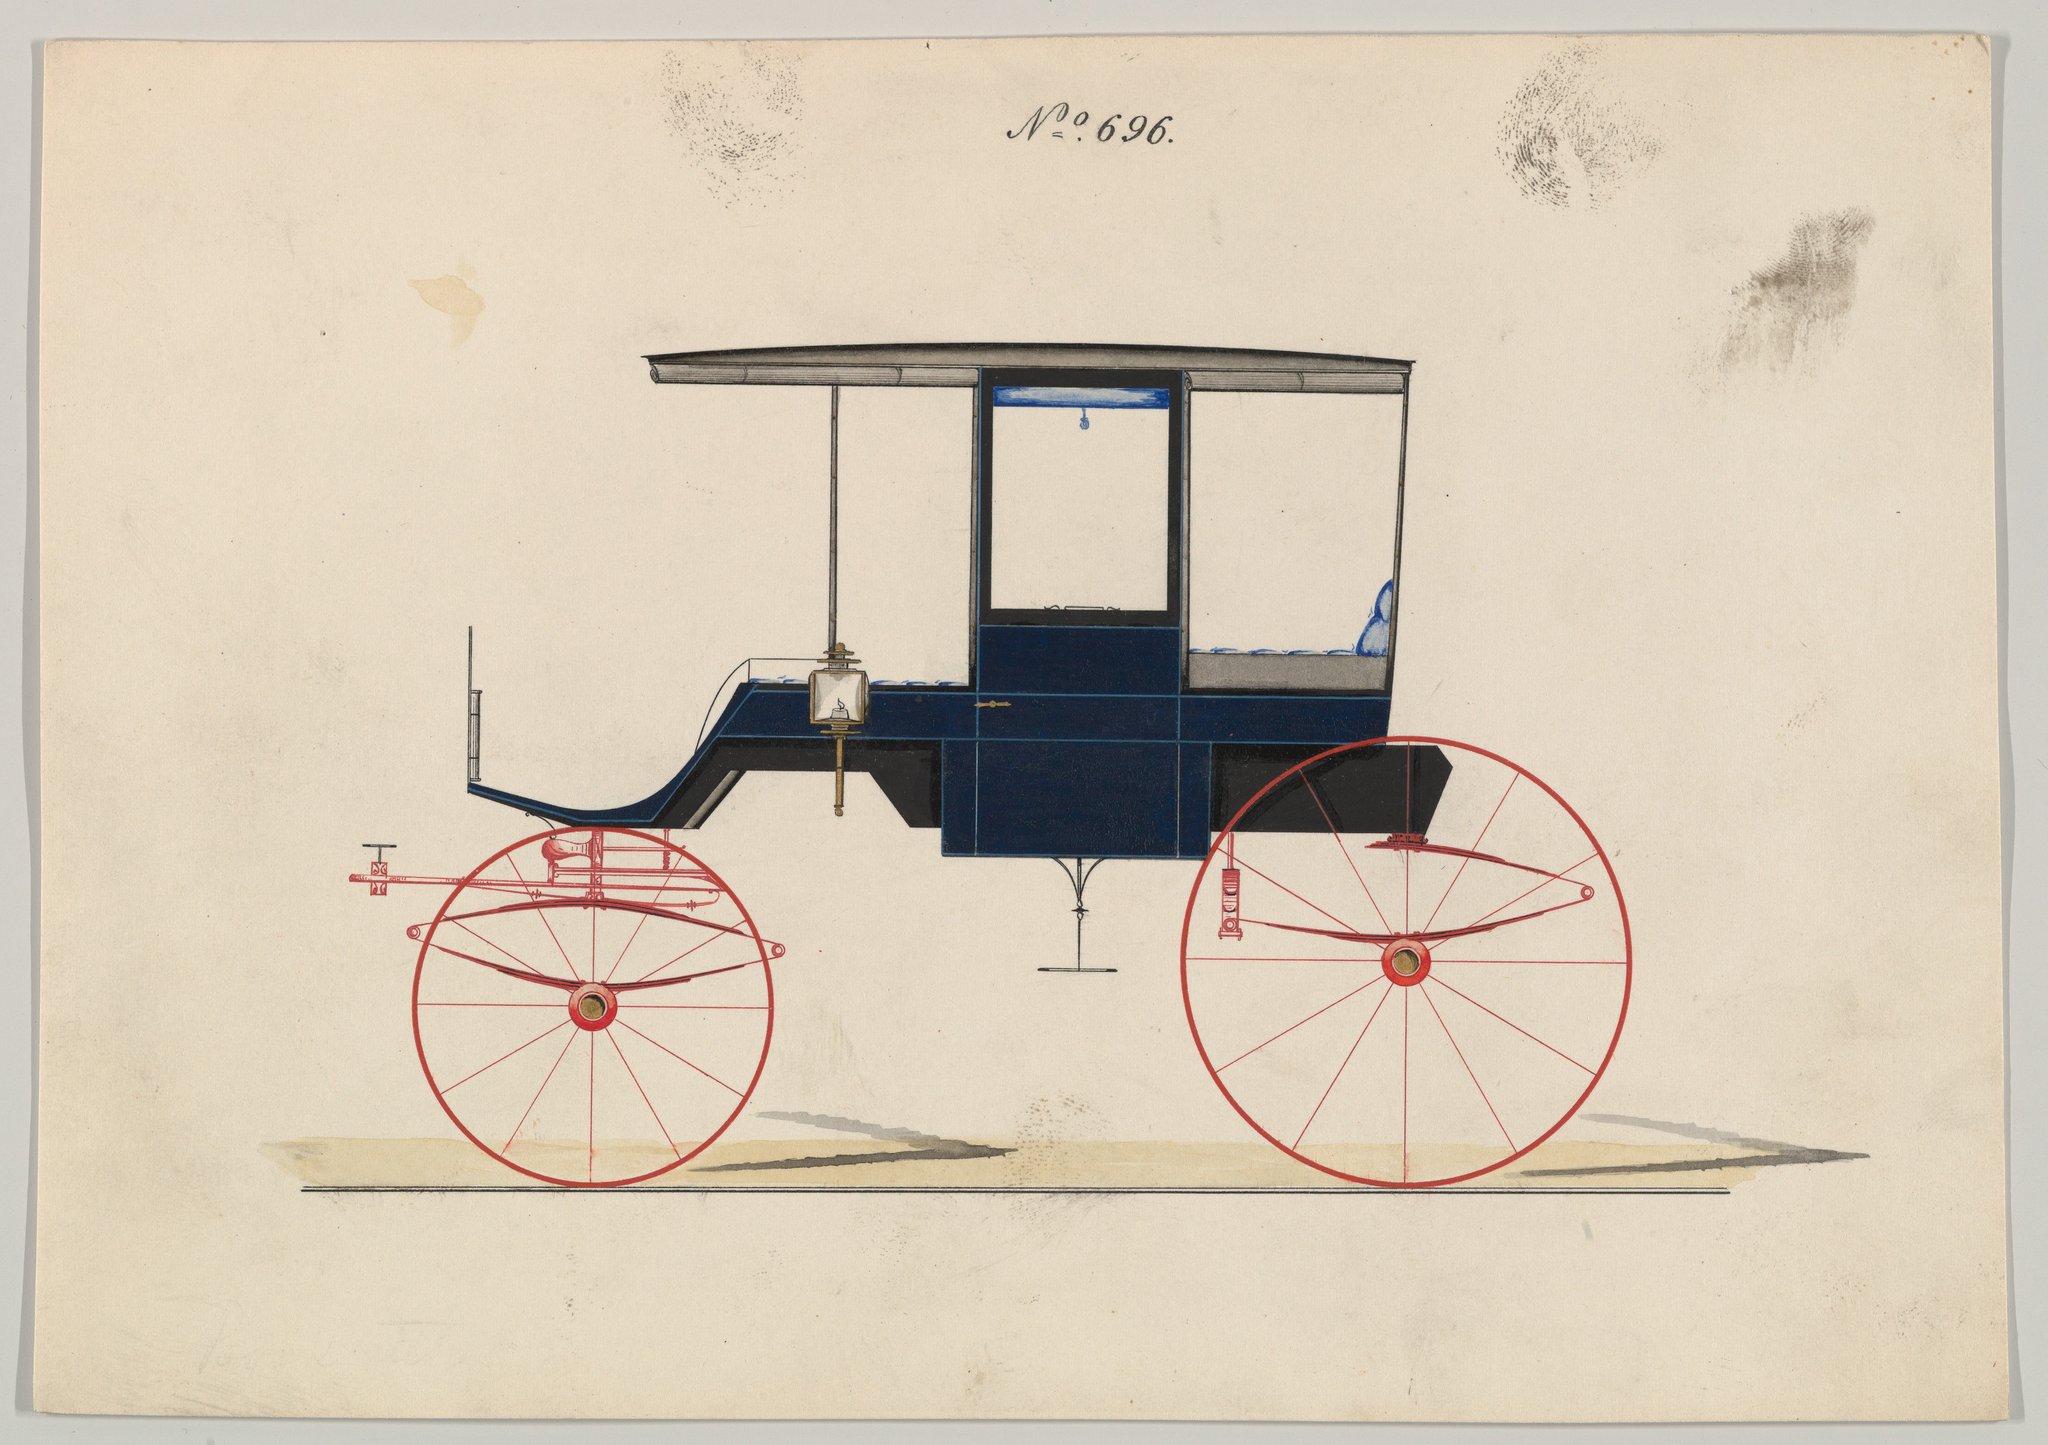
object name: drawing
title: Rockaway #696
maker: brewster & co.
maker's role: manufacturer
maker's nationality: american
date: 1865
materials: gouache, gum arabic, ink, watercolor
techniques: pen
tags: carriages